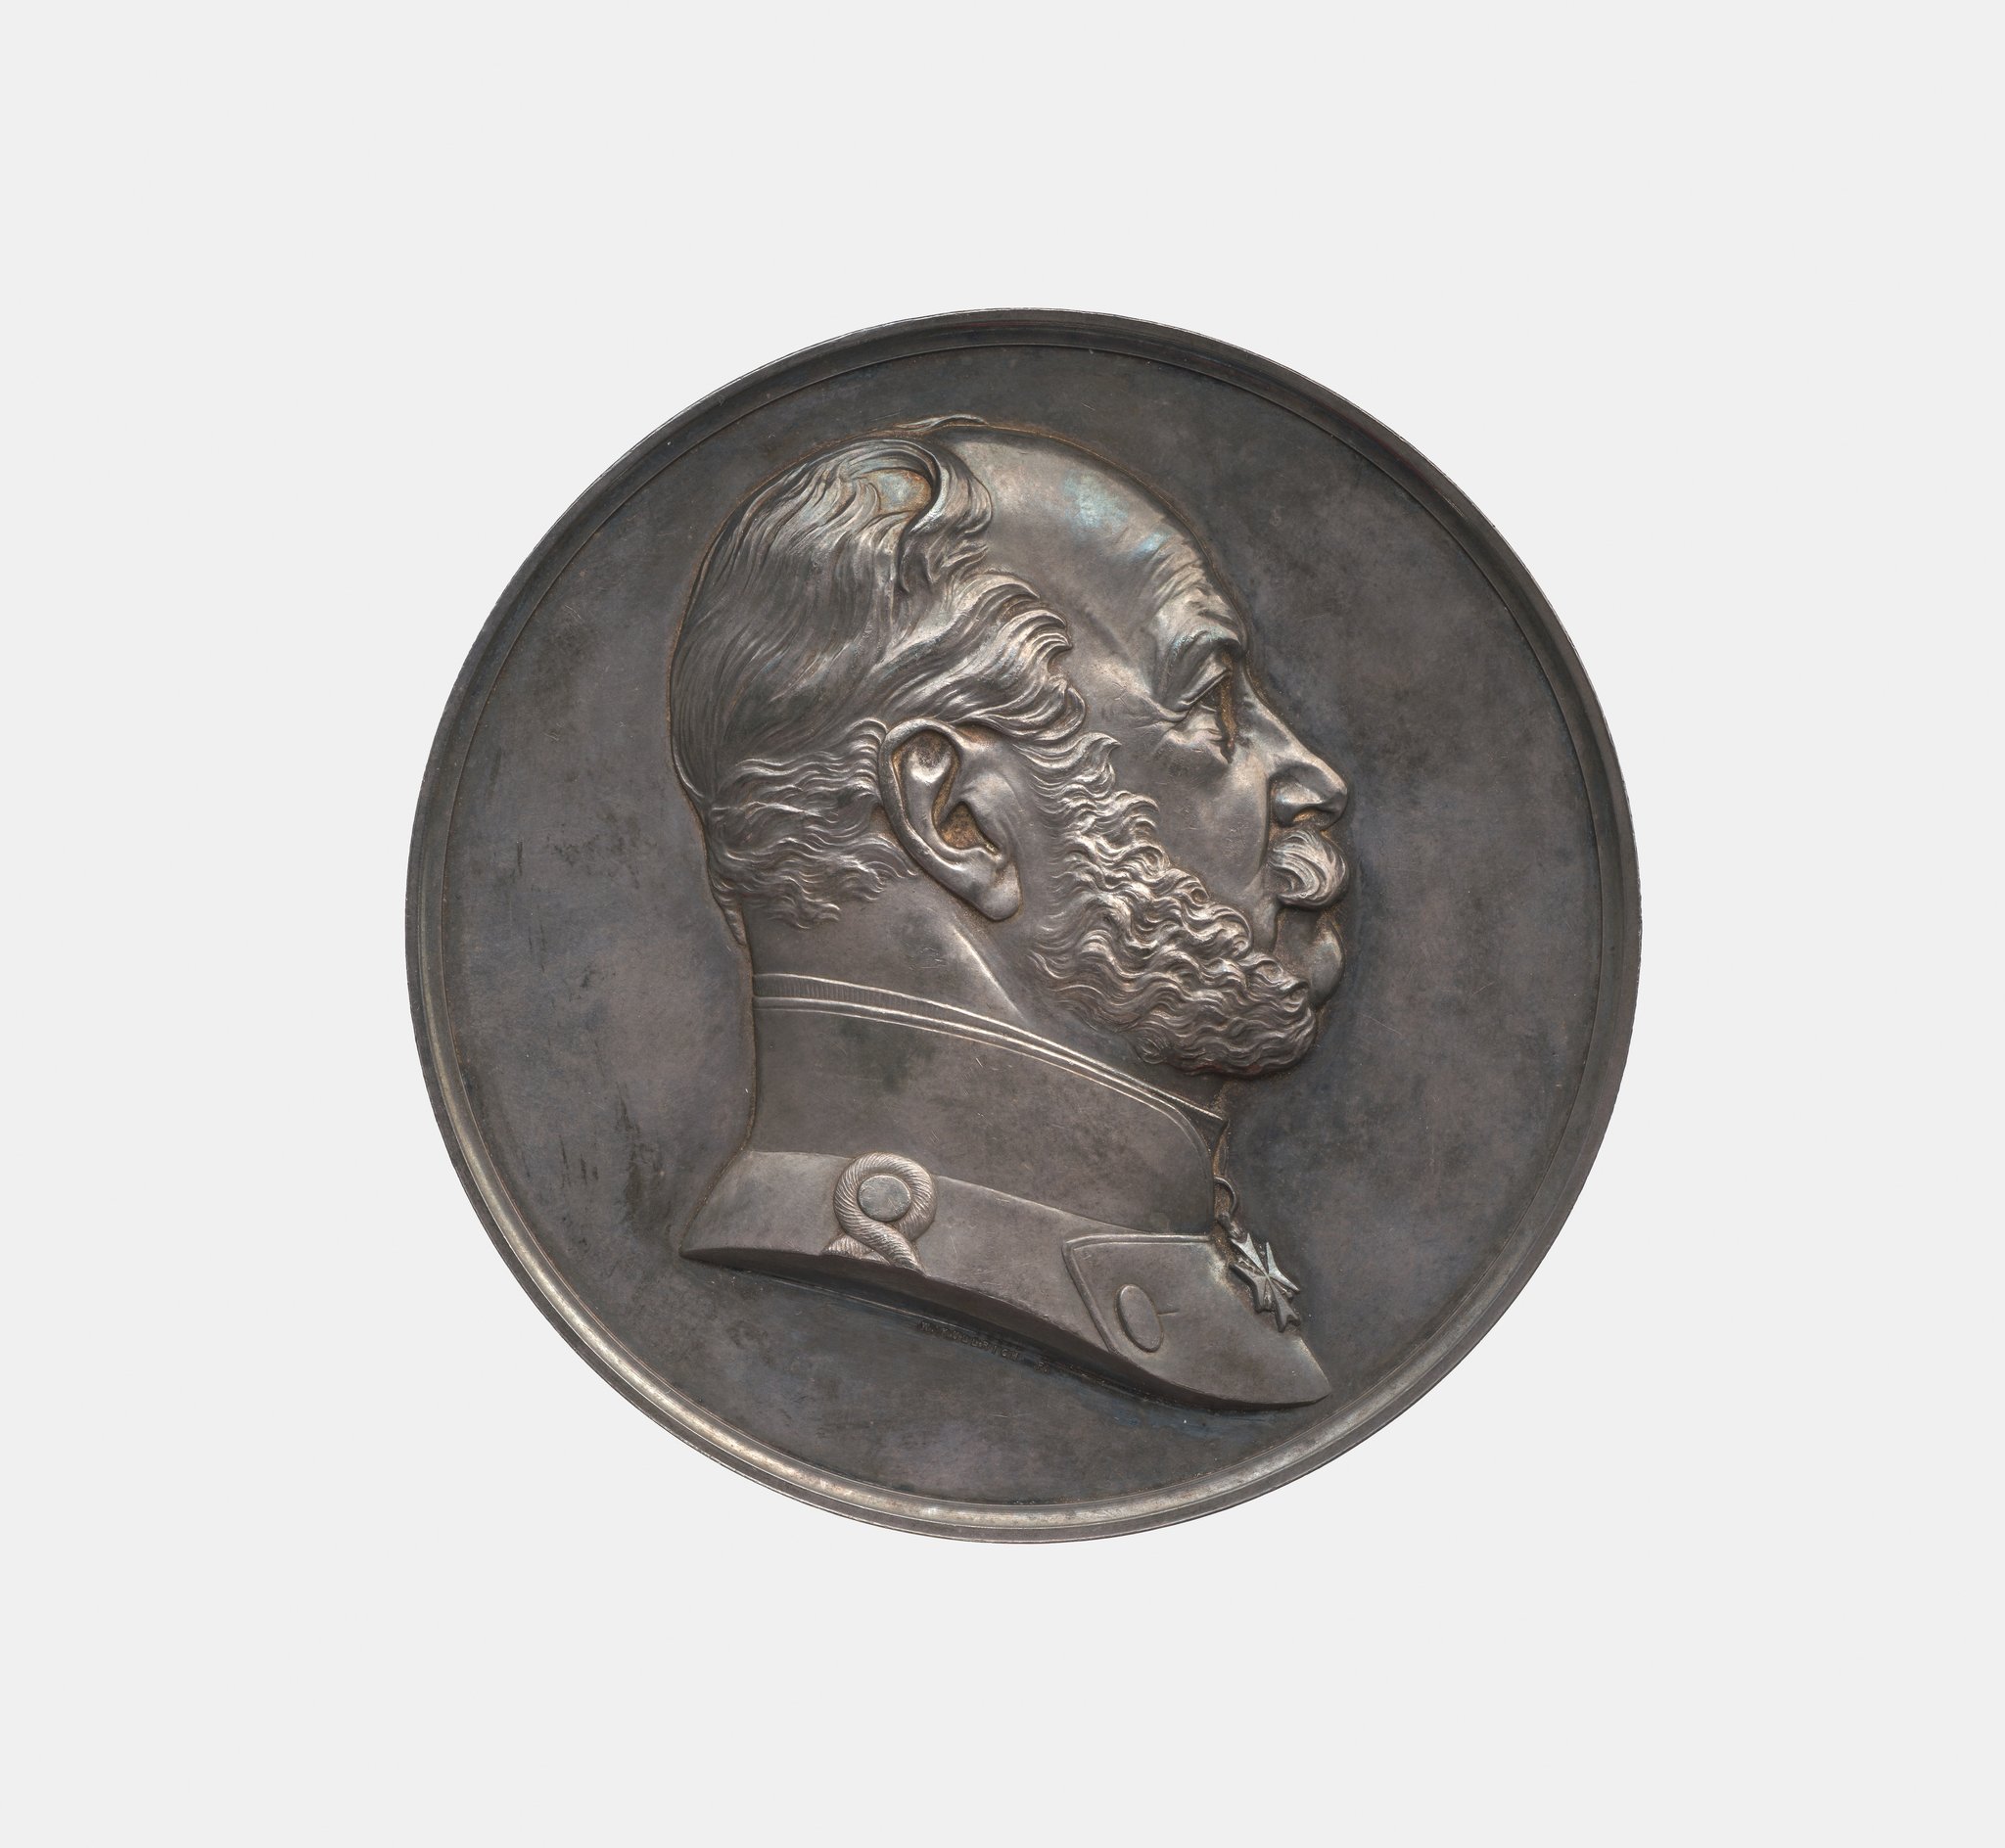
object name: medal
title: Wilhelm I (1797–1888)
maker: w. kullrich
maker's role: artist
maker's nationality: german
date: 1871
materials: silver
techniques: struck